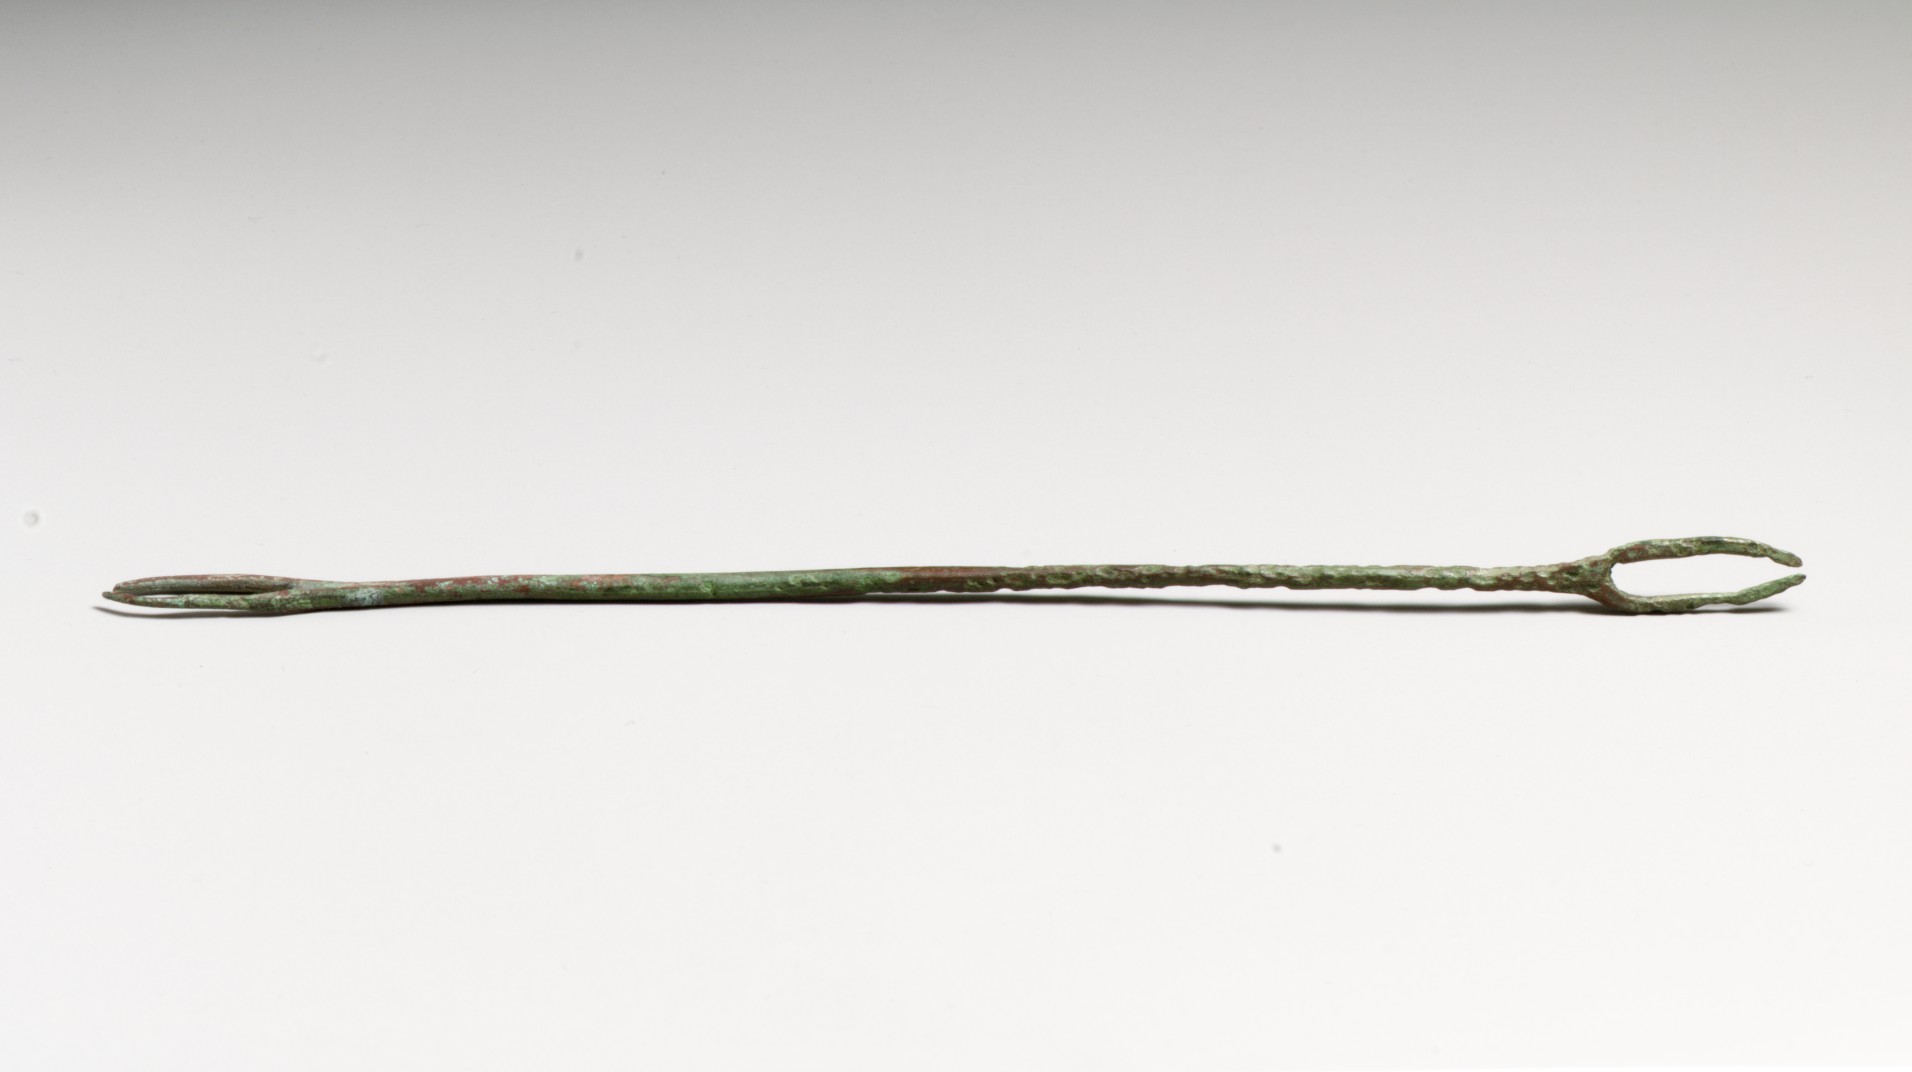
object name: needle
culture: cypriot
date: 3900 BCE-100 CE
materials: bronze